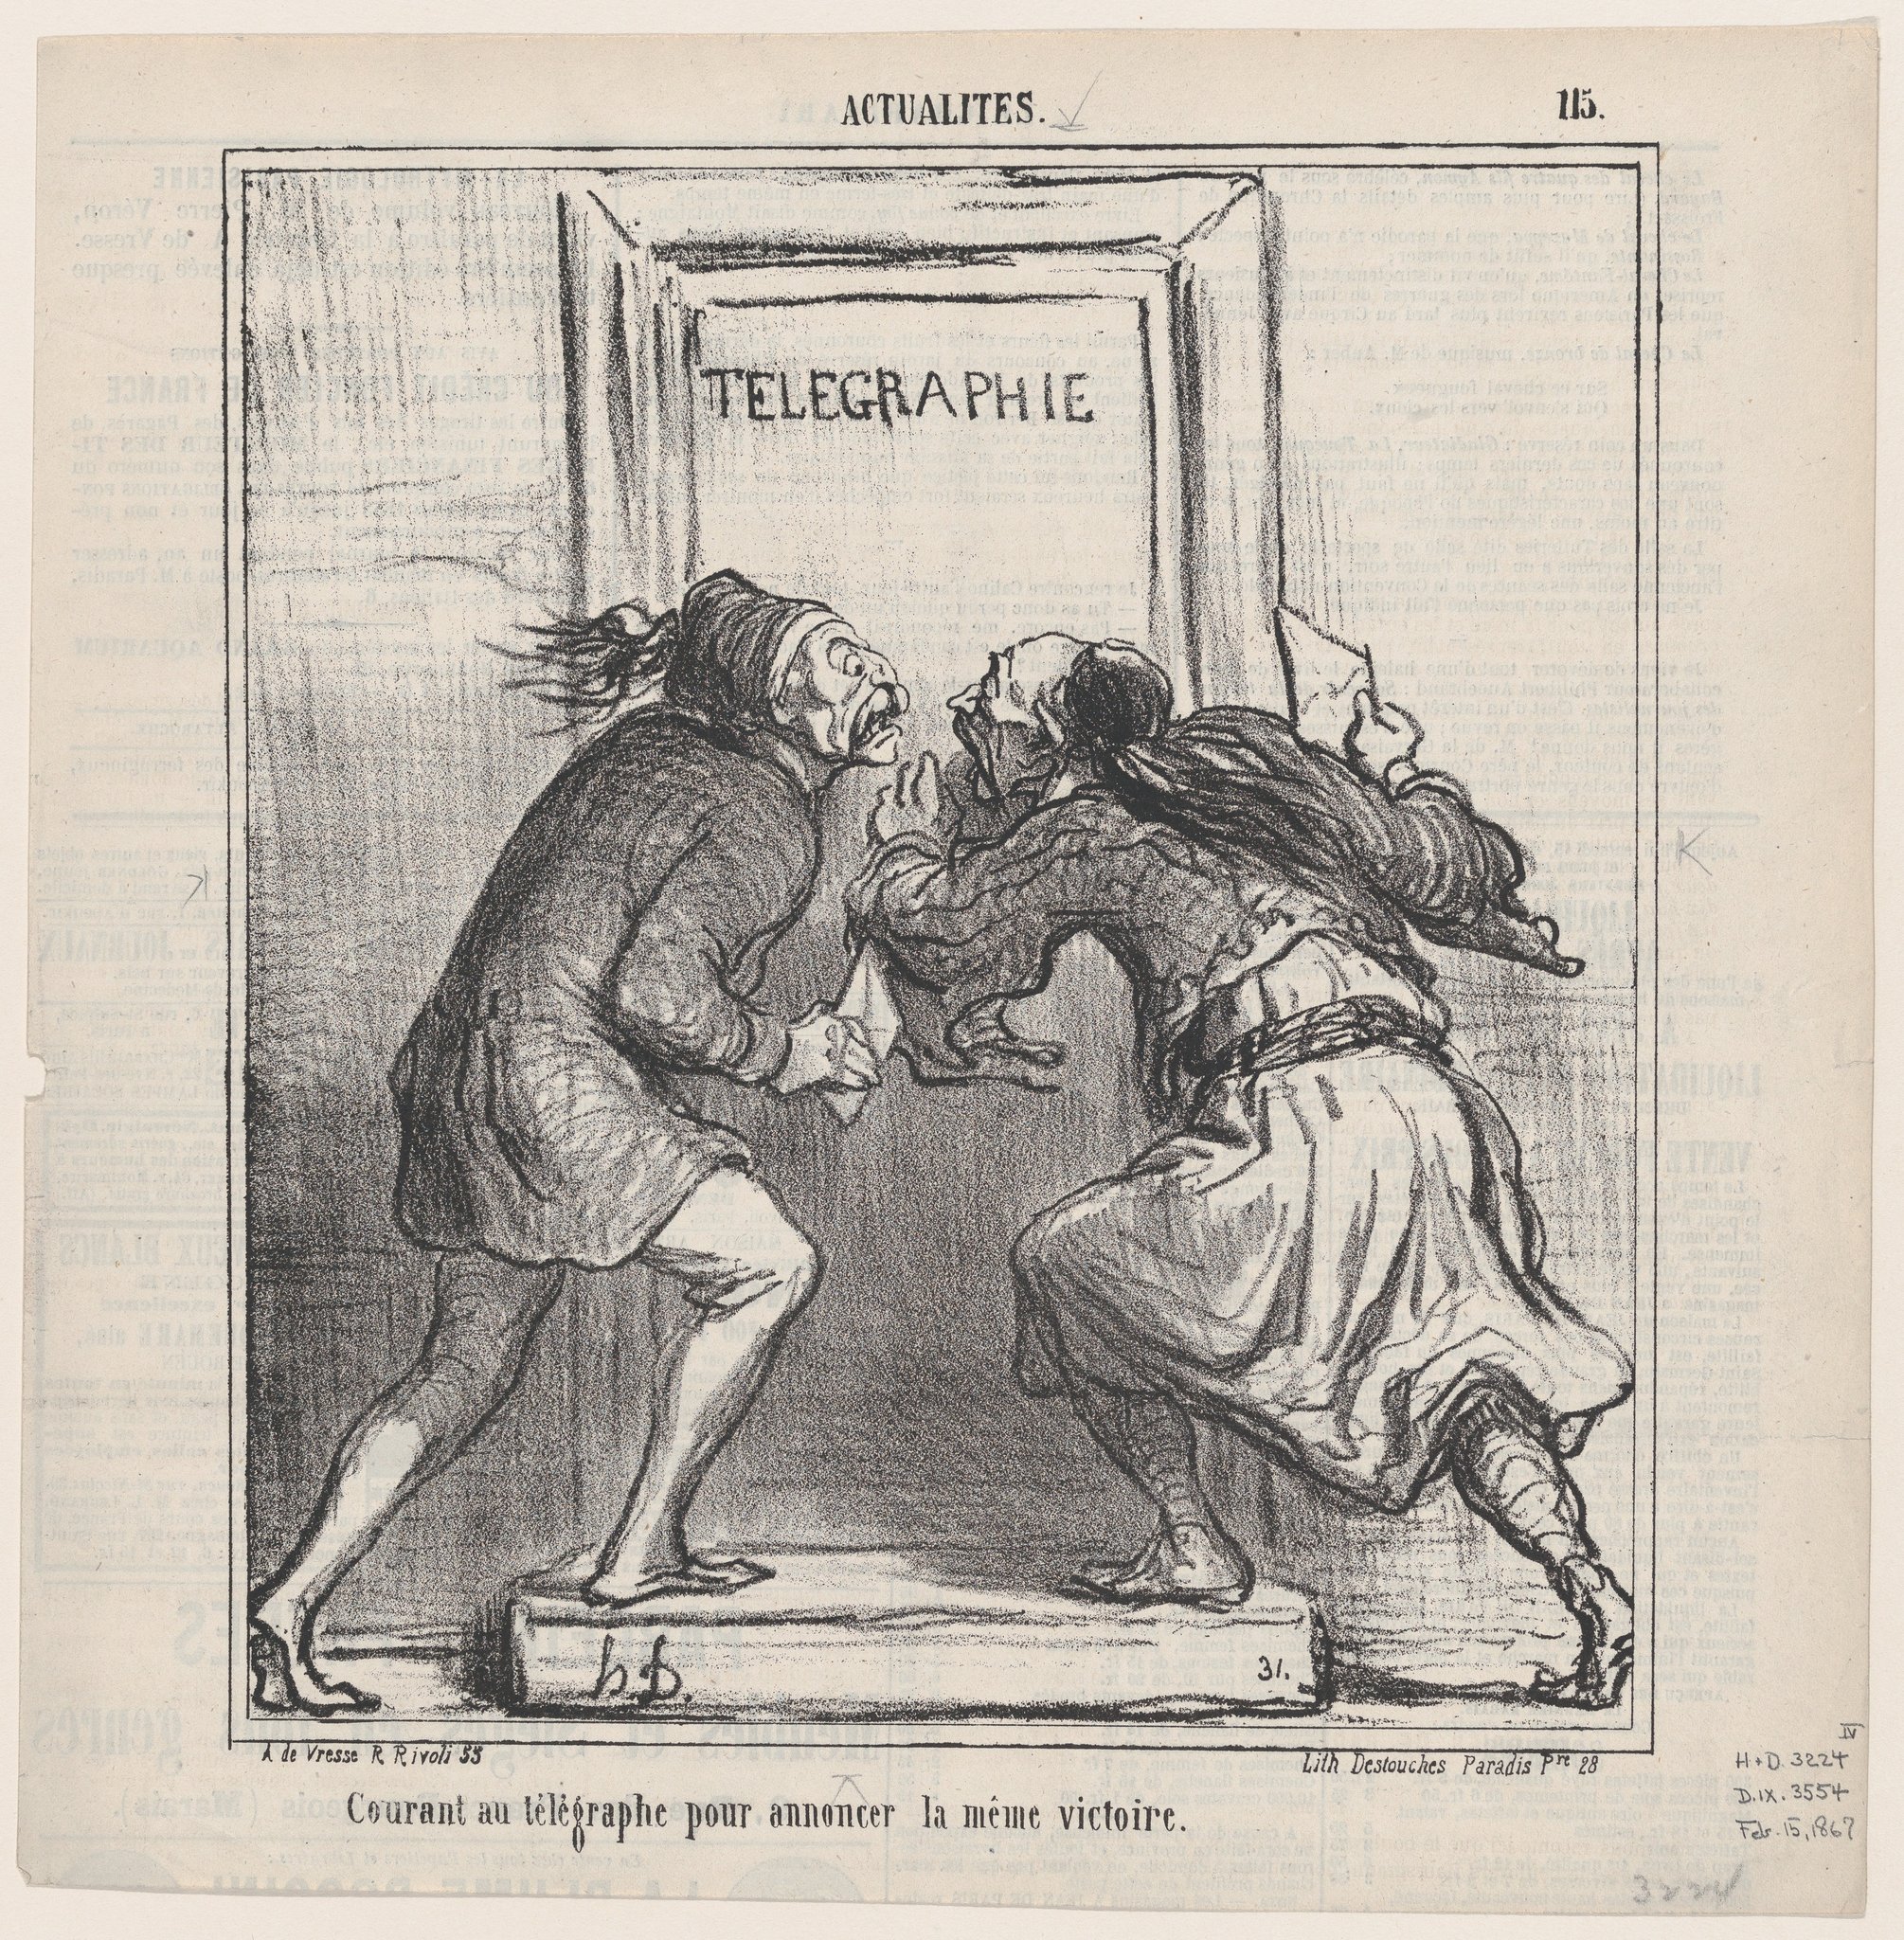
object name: print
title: Both running to the telegraph office to announce the same victory, from "News of the Day"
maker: honoré daumier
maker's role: artist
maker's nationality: french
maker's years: 1808-1879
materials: paper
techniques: lithograph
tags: men